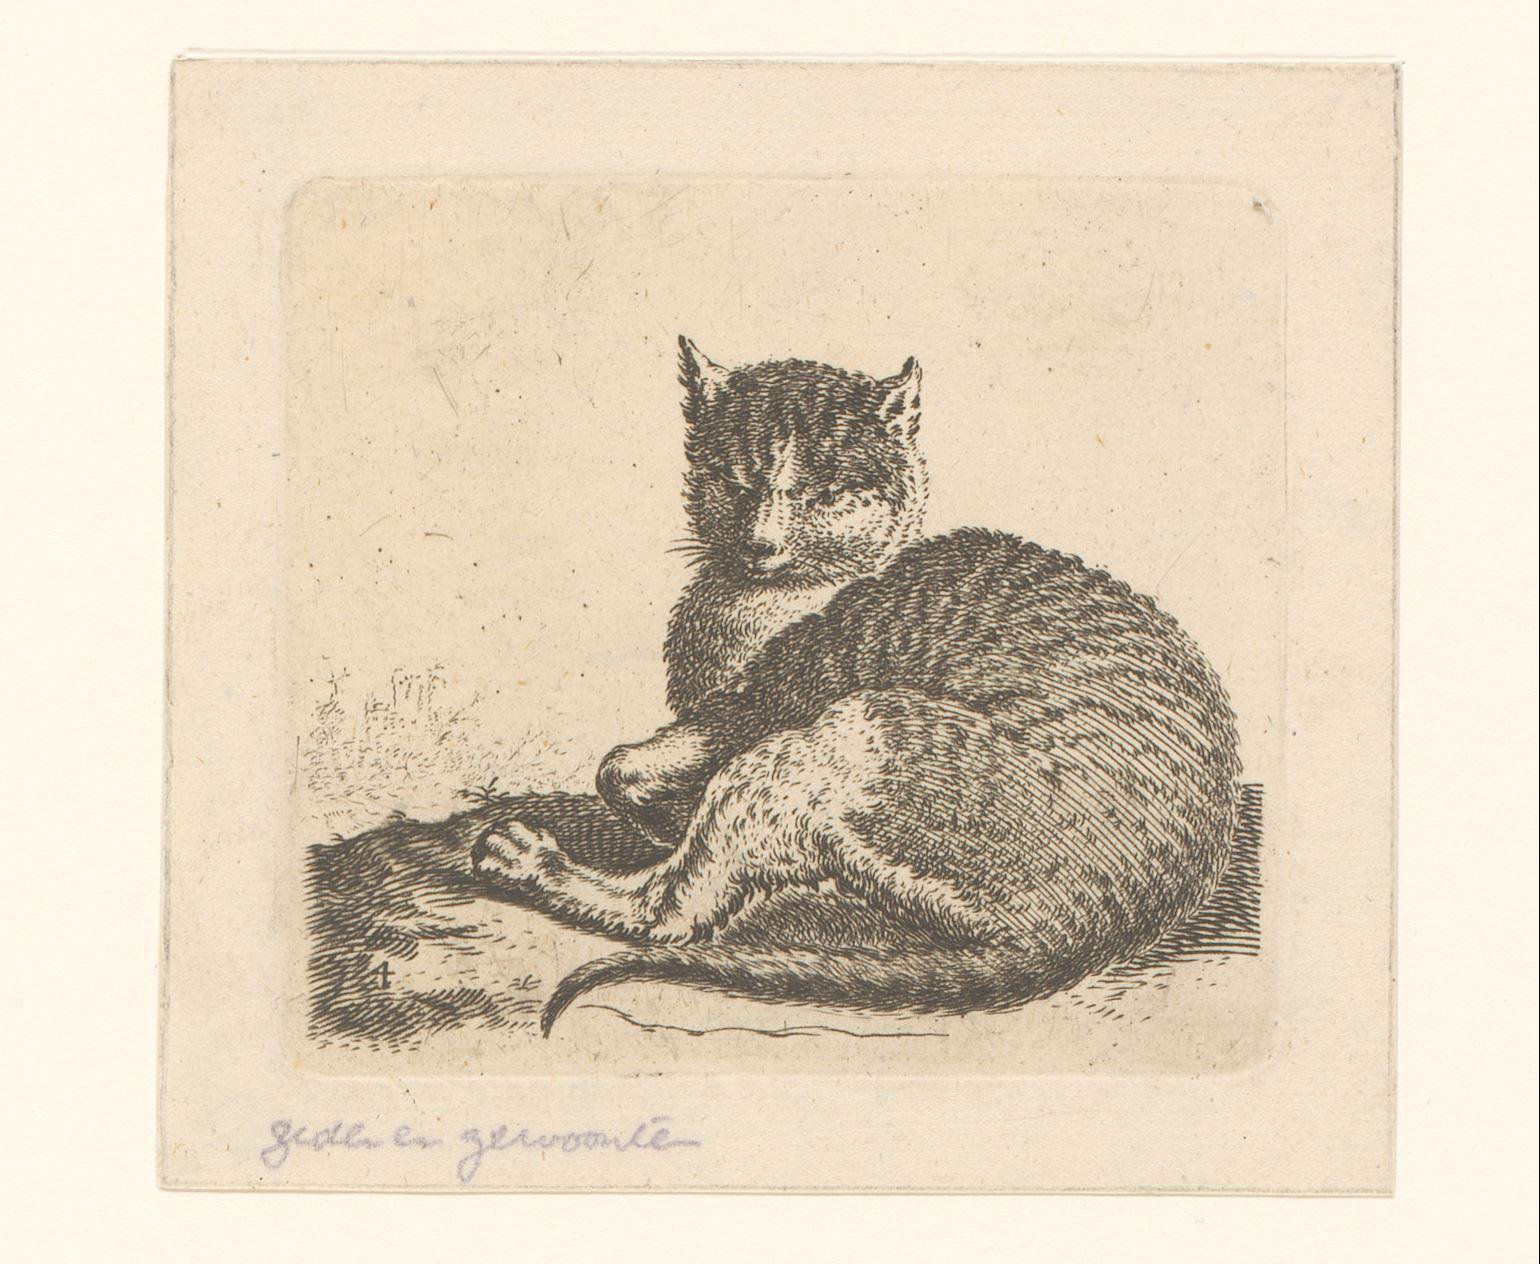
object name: print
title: Liggende poes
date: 1617-1681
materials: paper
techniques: etching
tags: animals, cat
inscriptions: collector's mark: Lugt 2228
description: Maakt deel uit van een twaalfdelige serie met boerderijbeesten.